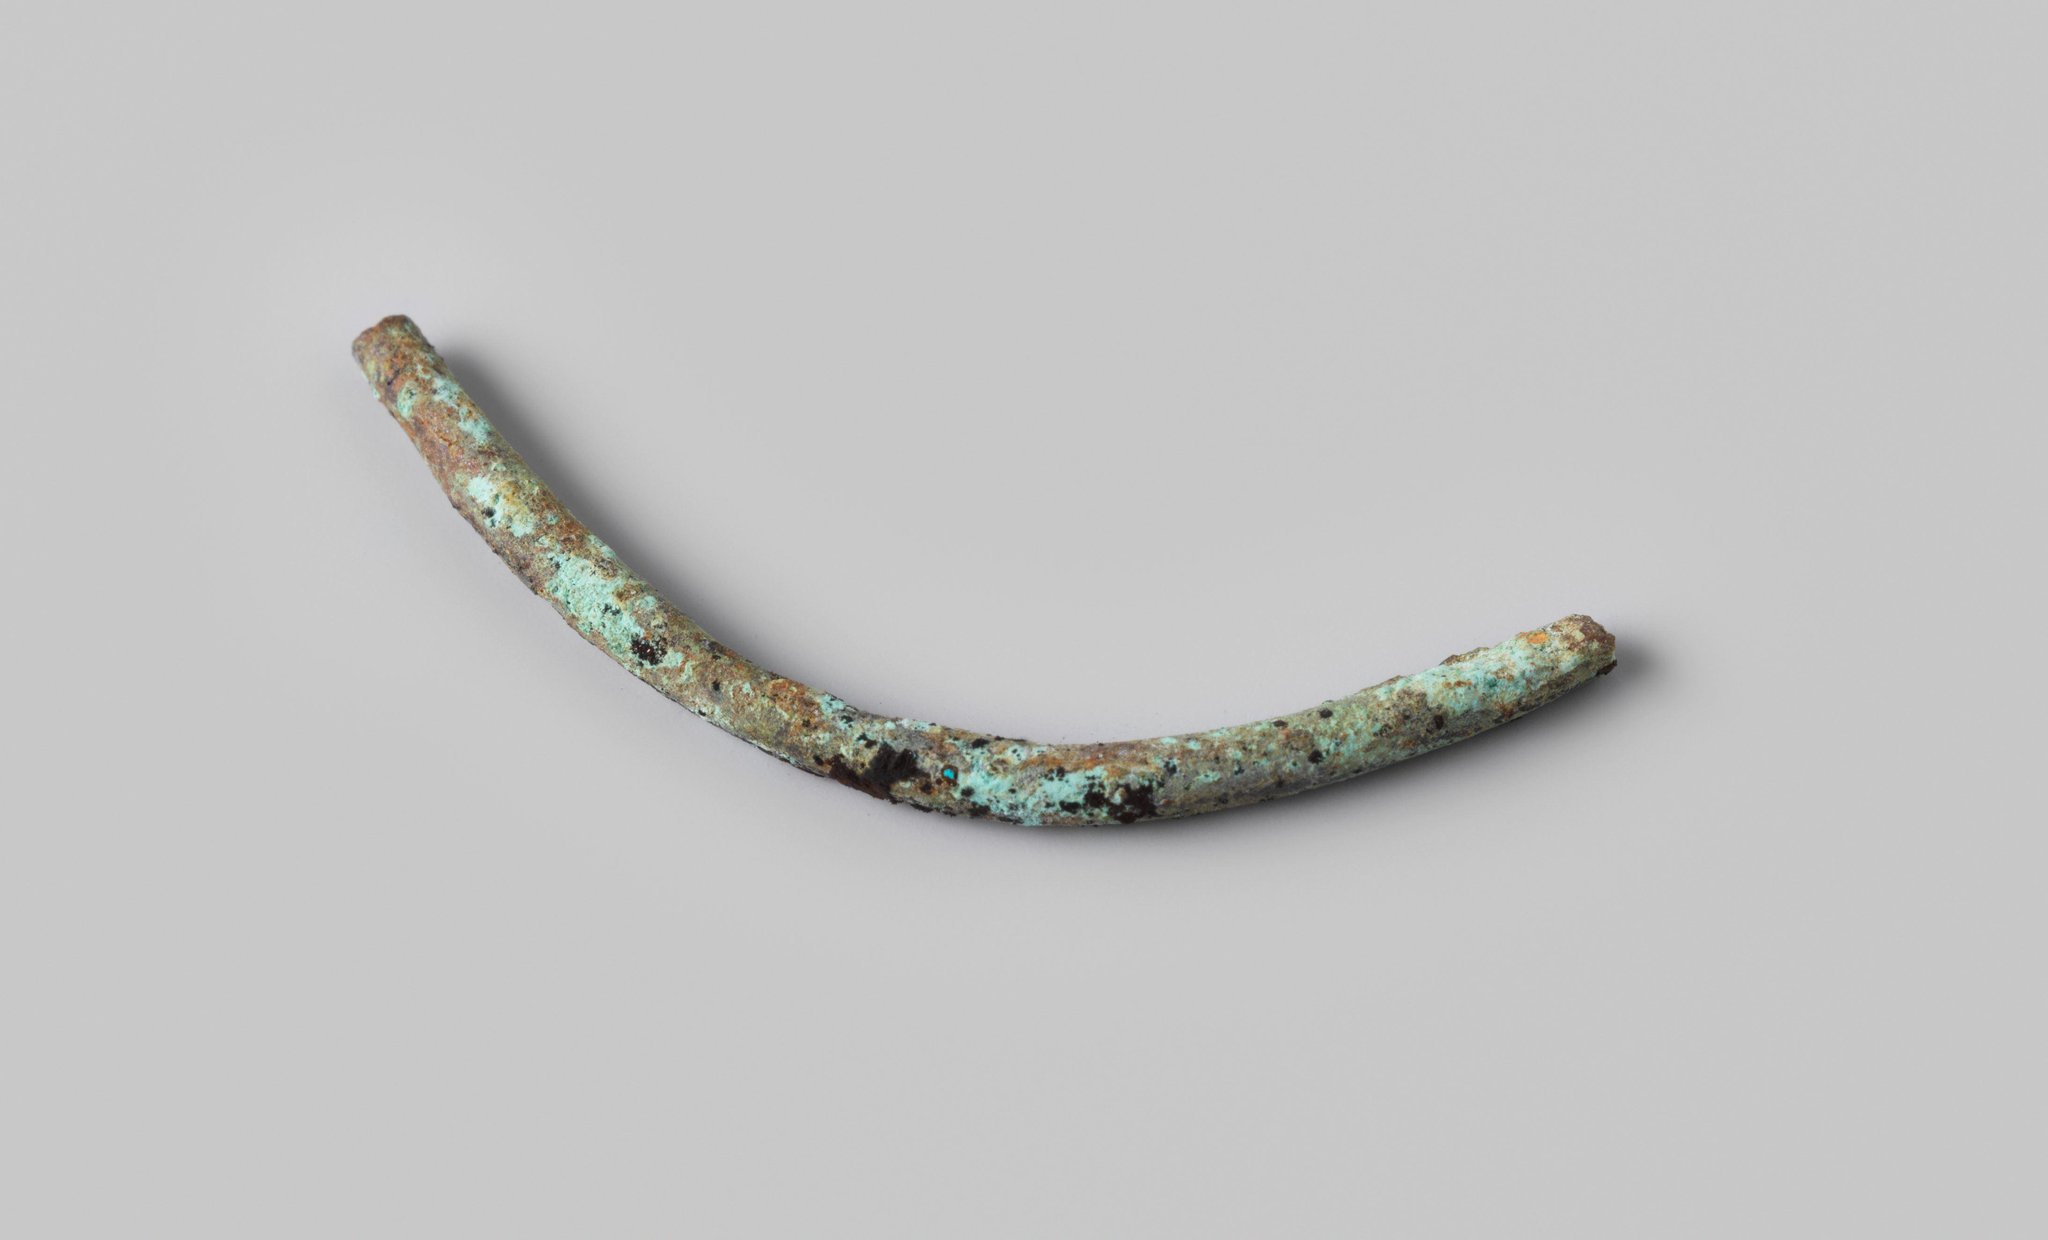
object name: wire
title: Koperdraad uit het wrak van de Oost-Indiëvaarder Hollandia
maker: Anonymous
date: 1700-1743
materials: copper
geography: netherlands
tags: verenigde oostindische compagnie, hollandia (schip), annet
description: Varied parts or fragments, wire; fragm, eroded, bent, circular in section.